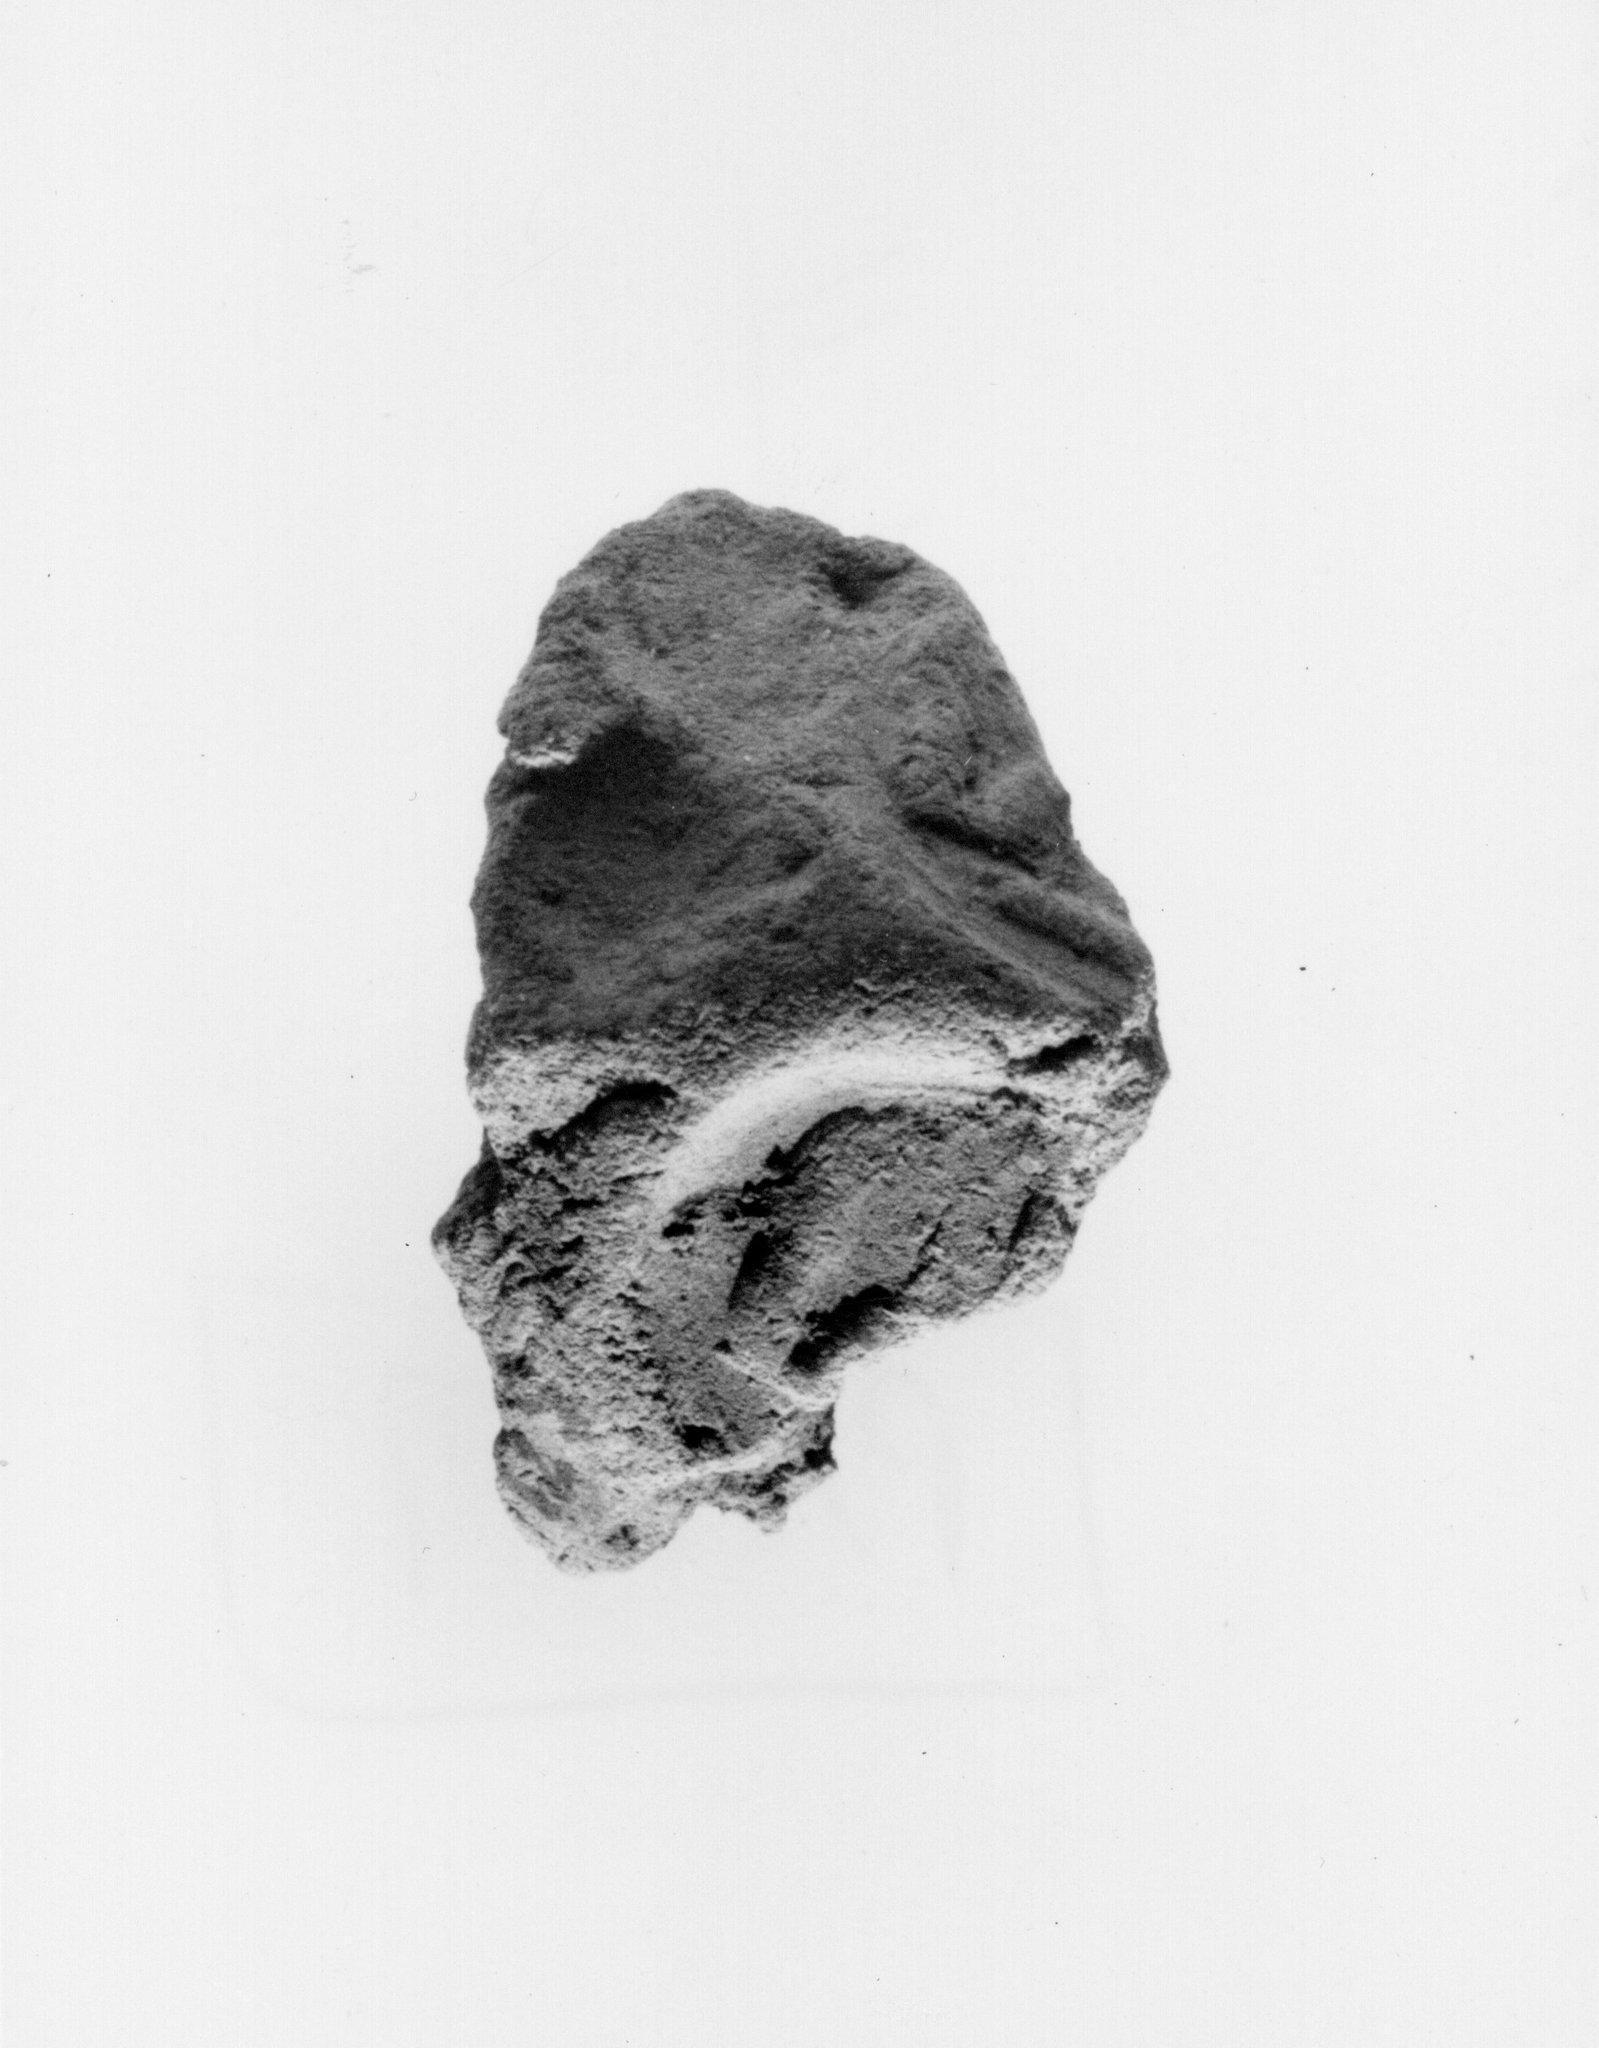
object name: sealing, nebmaatre, amenhotep iii, thoth, double crown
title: Document Sealing With the Throne Name of Amenhotep III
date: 1390-1352 BCE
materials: mud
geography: egypt